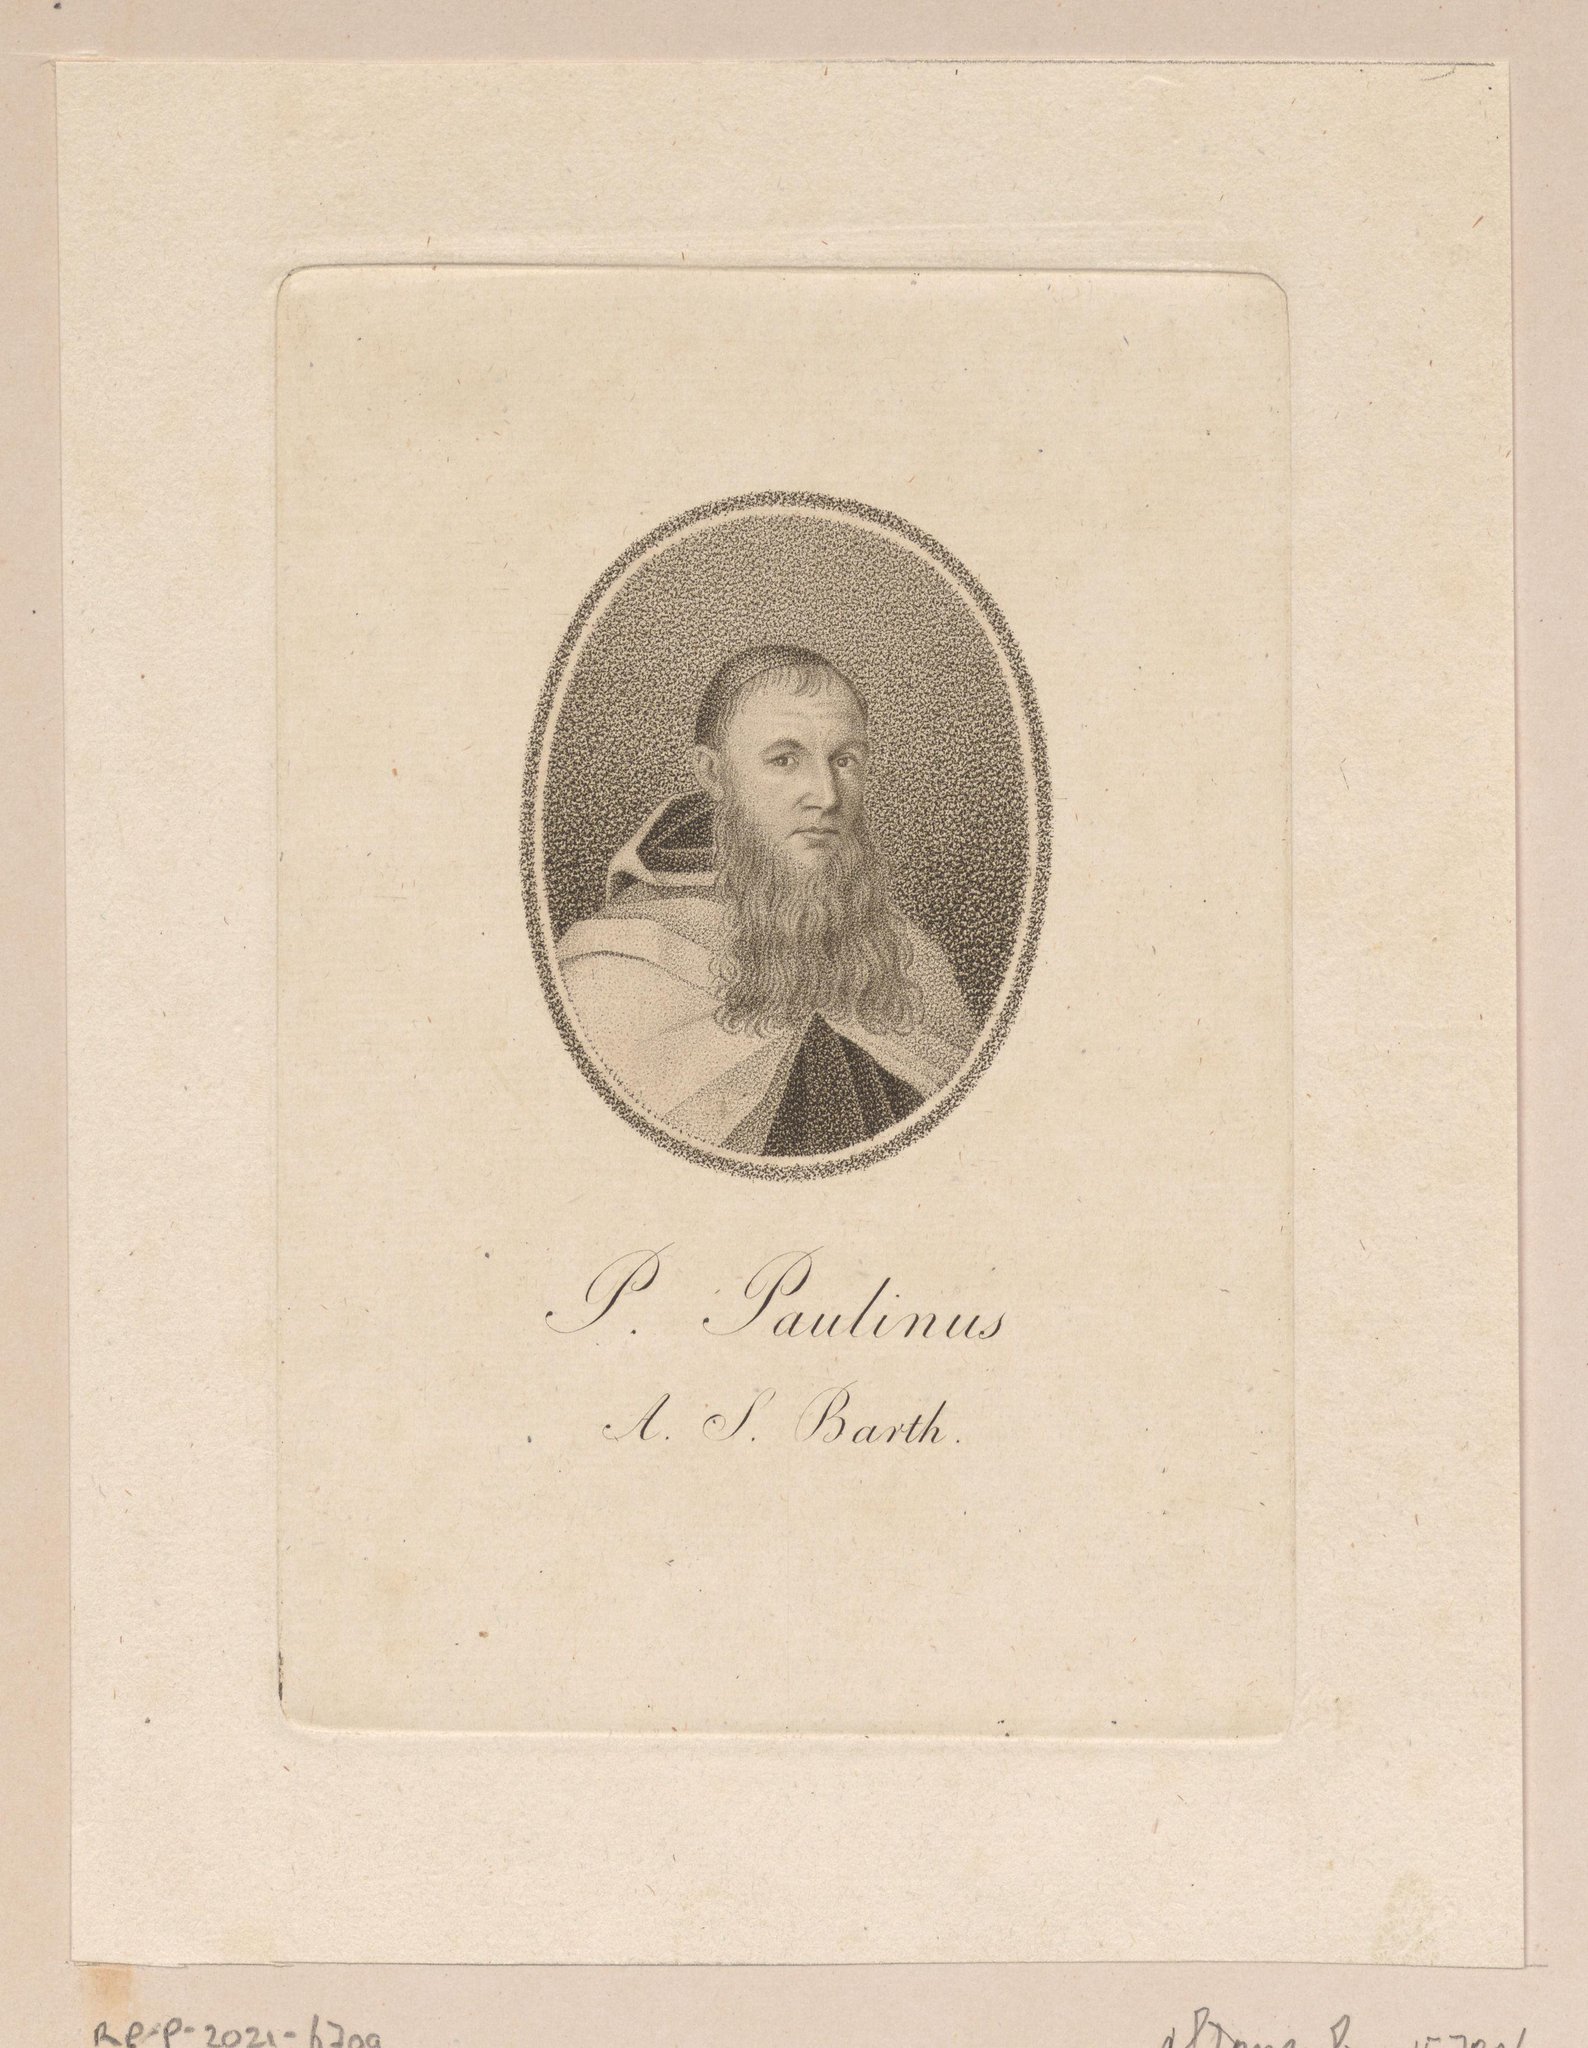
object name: print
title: Portret van Paulinus van Sint-Bartolomeüs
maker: Anonymous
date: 1774-1824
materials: paper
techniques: engraving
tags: rome, missionary, adult man, historical persons, organization, functionaries and dignitaries in roman catholic church; clergy in general